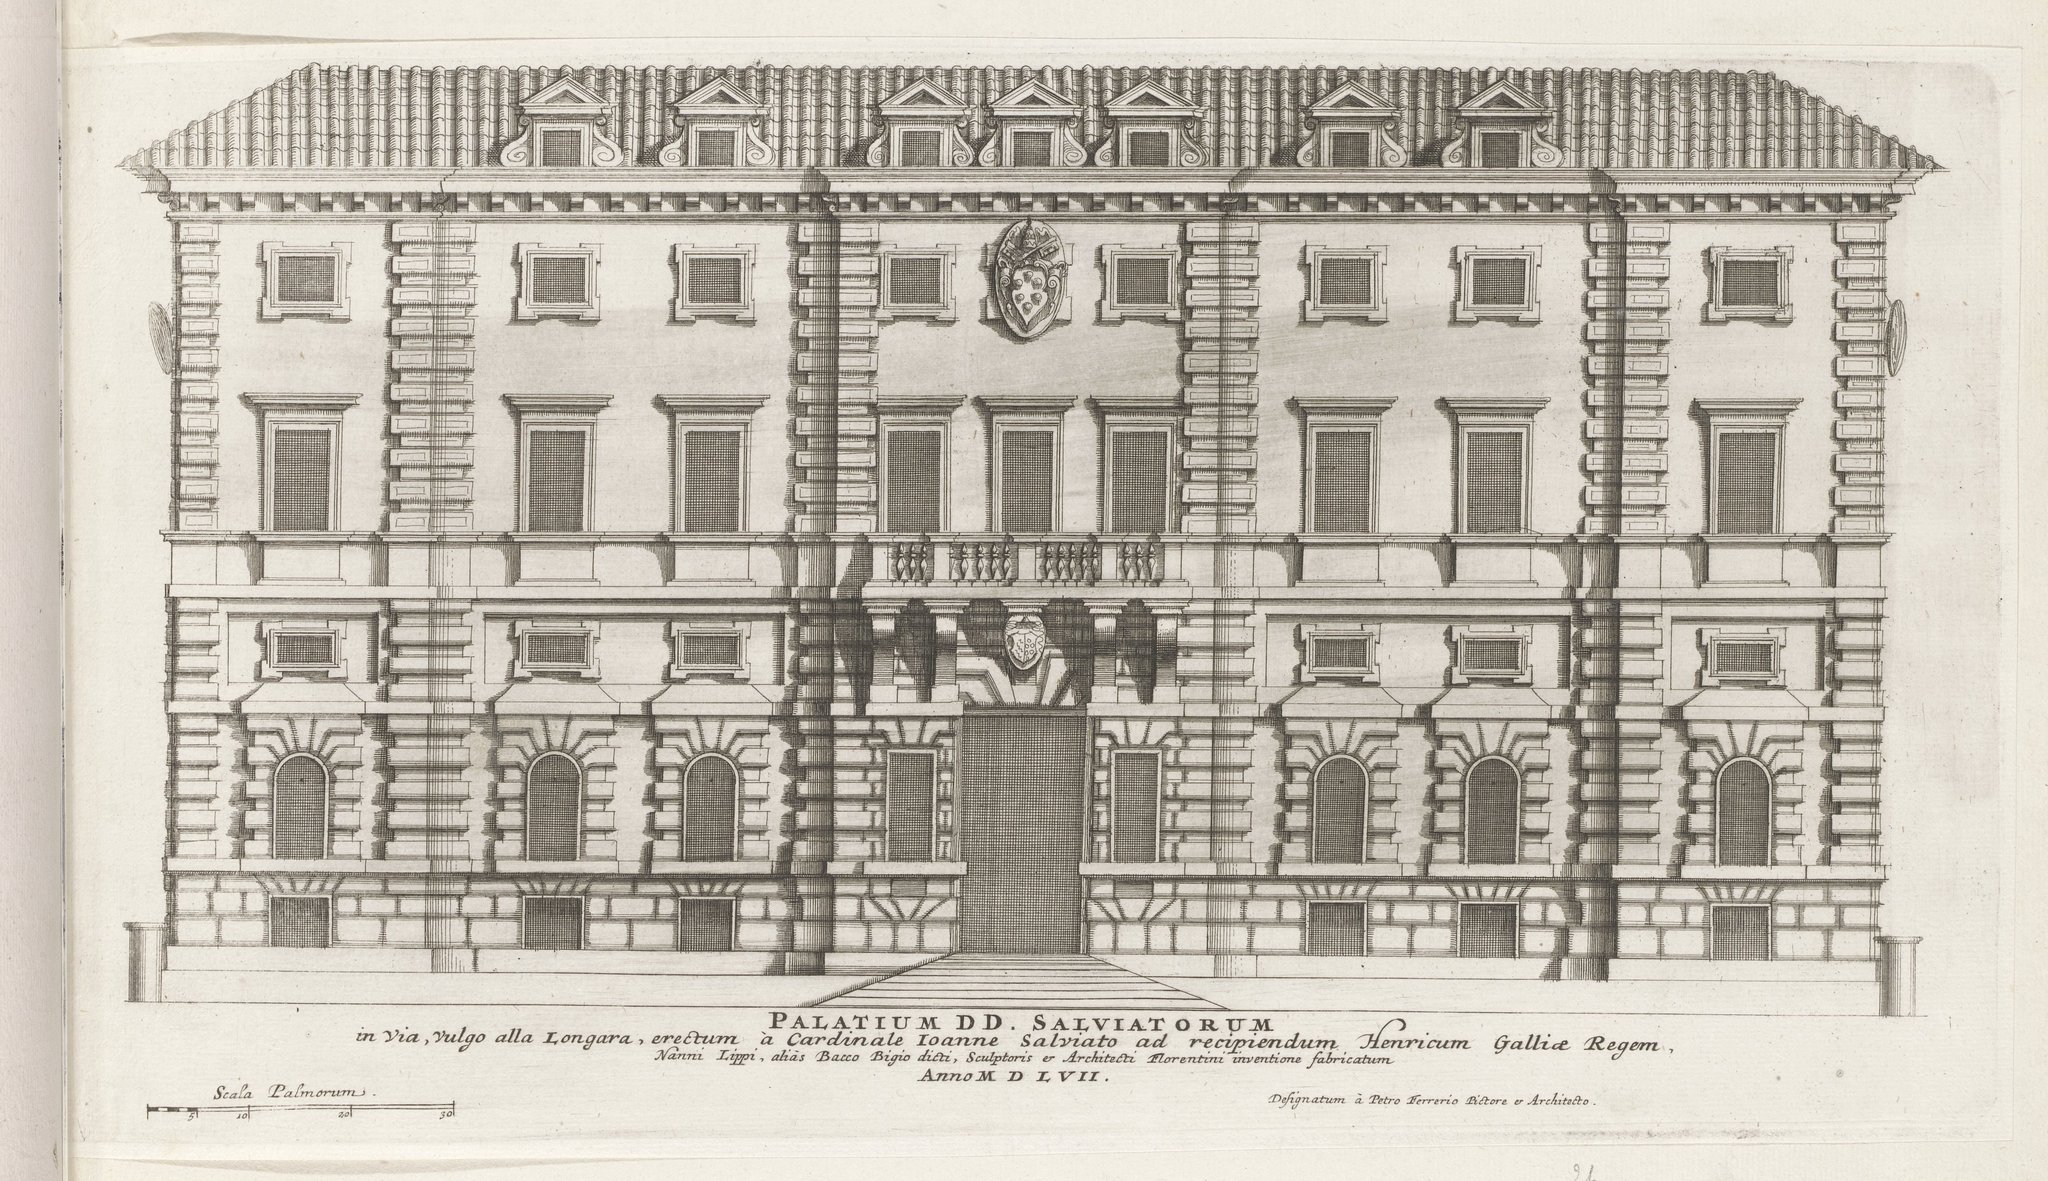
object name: print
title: Palazzi di Roma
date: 1655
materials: paper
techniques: etching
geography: rome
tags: clergyman, urbanus viii, palace, façade (of house or building)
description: Deze prent maakt deel uit van de reeks getiteld: Palazzi di Roma. Deze reeks bestaat uit twee boeken. Boek één getiteld: Palazzi di Roma dei più celebri architetti..., bestaat uit 44 prenten die worden toegeschreven aan Giovanni Battista Falda (naam staat enkel op prent 27) en uitgegeven door Giovanni Giacomo de'Rossi. Deze 44 prenten zijn bekend in twee staten (met en zonder nummer). Boek twee getiteld: Nuovi disegni dell'architetture... libro secondo, bevat 66 prenten door Giovanni Battista Falda en Simone Felice. Deze 66 prenten zijn bekend in twee staten (met en zonder nummer).